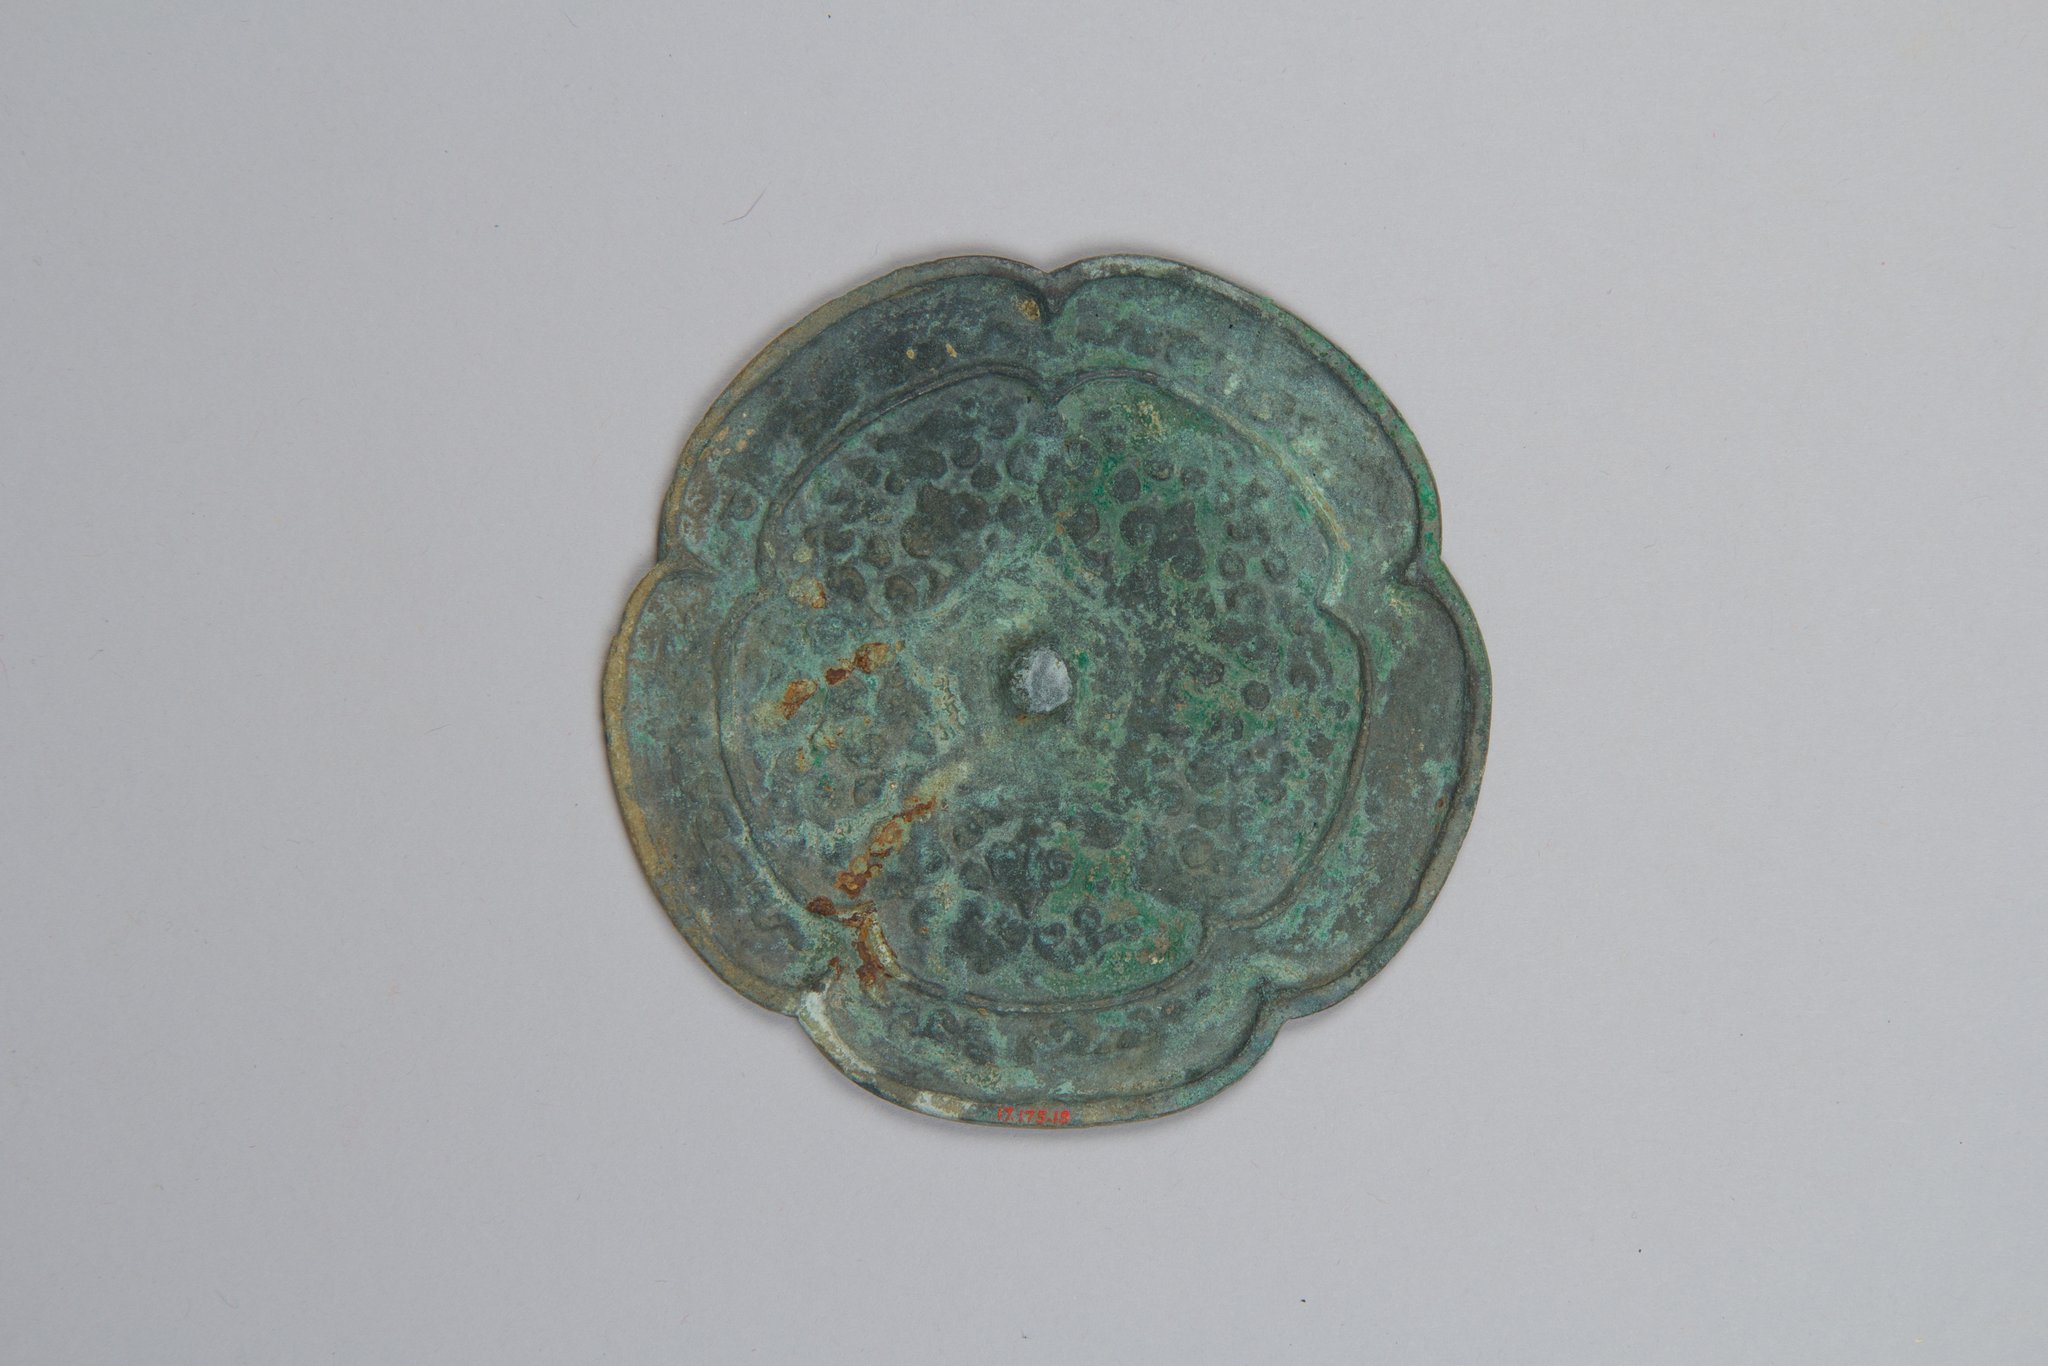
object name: mirror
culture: korean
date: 918-1392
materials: bronze